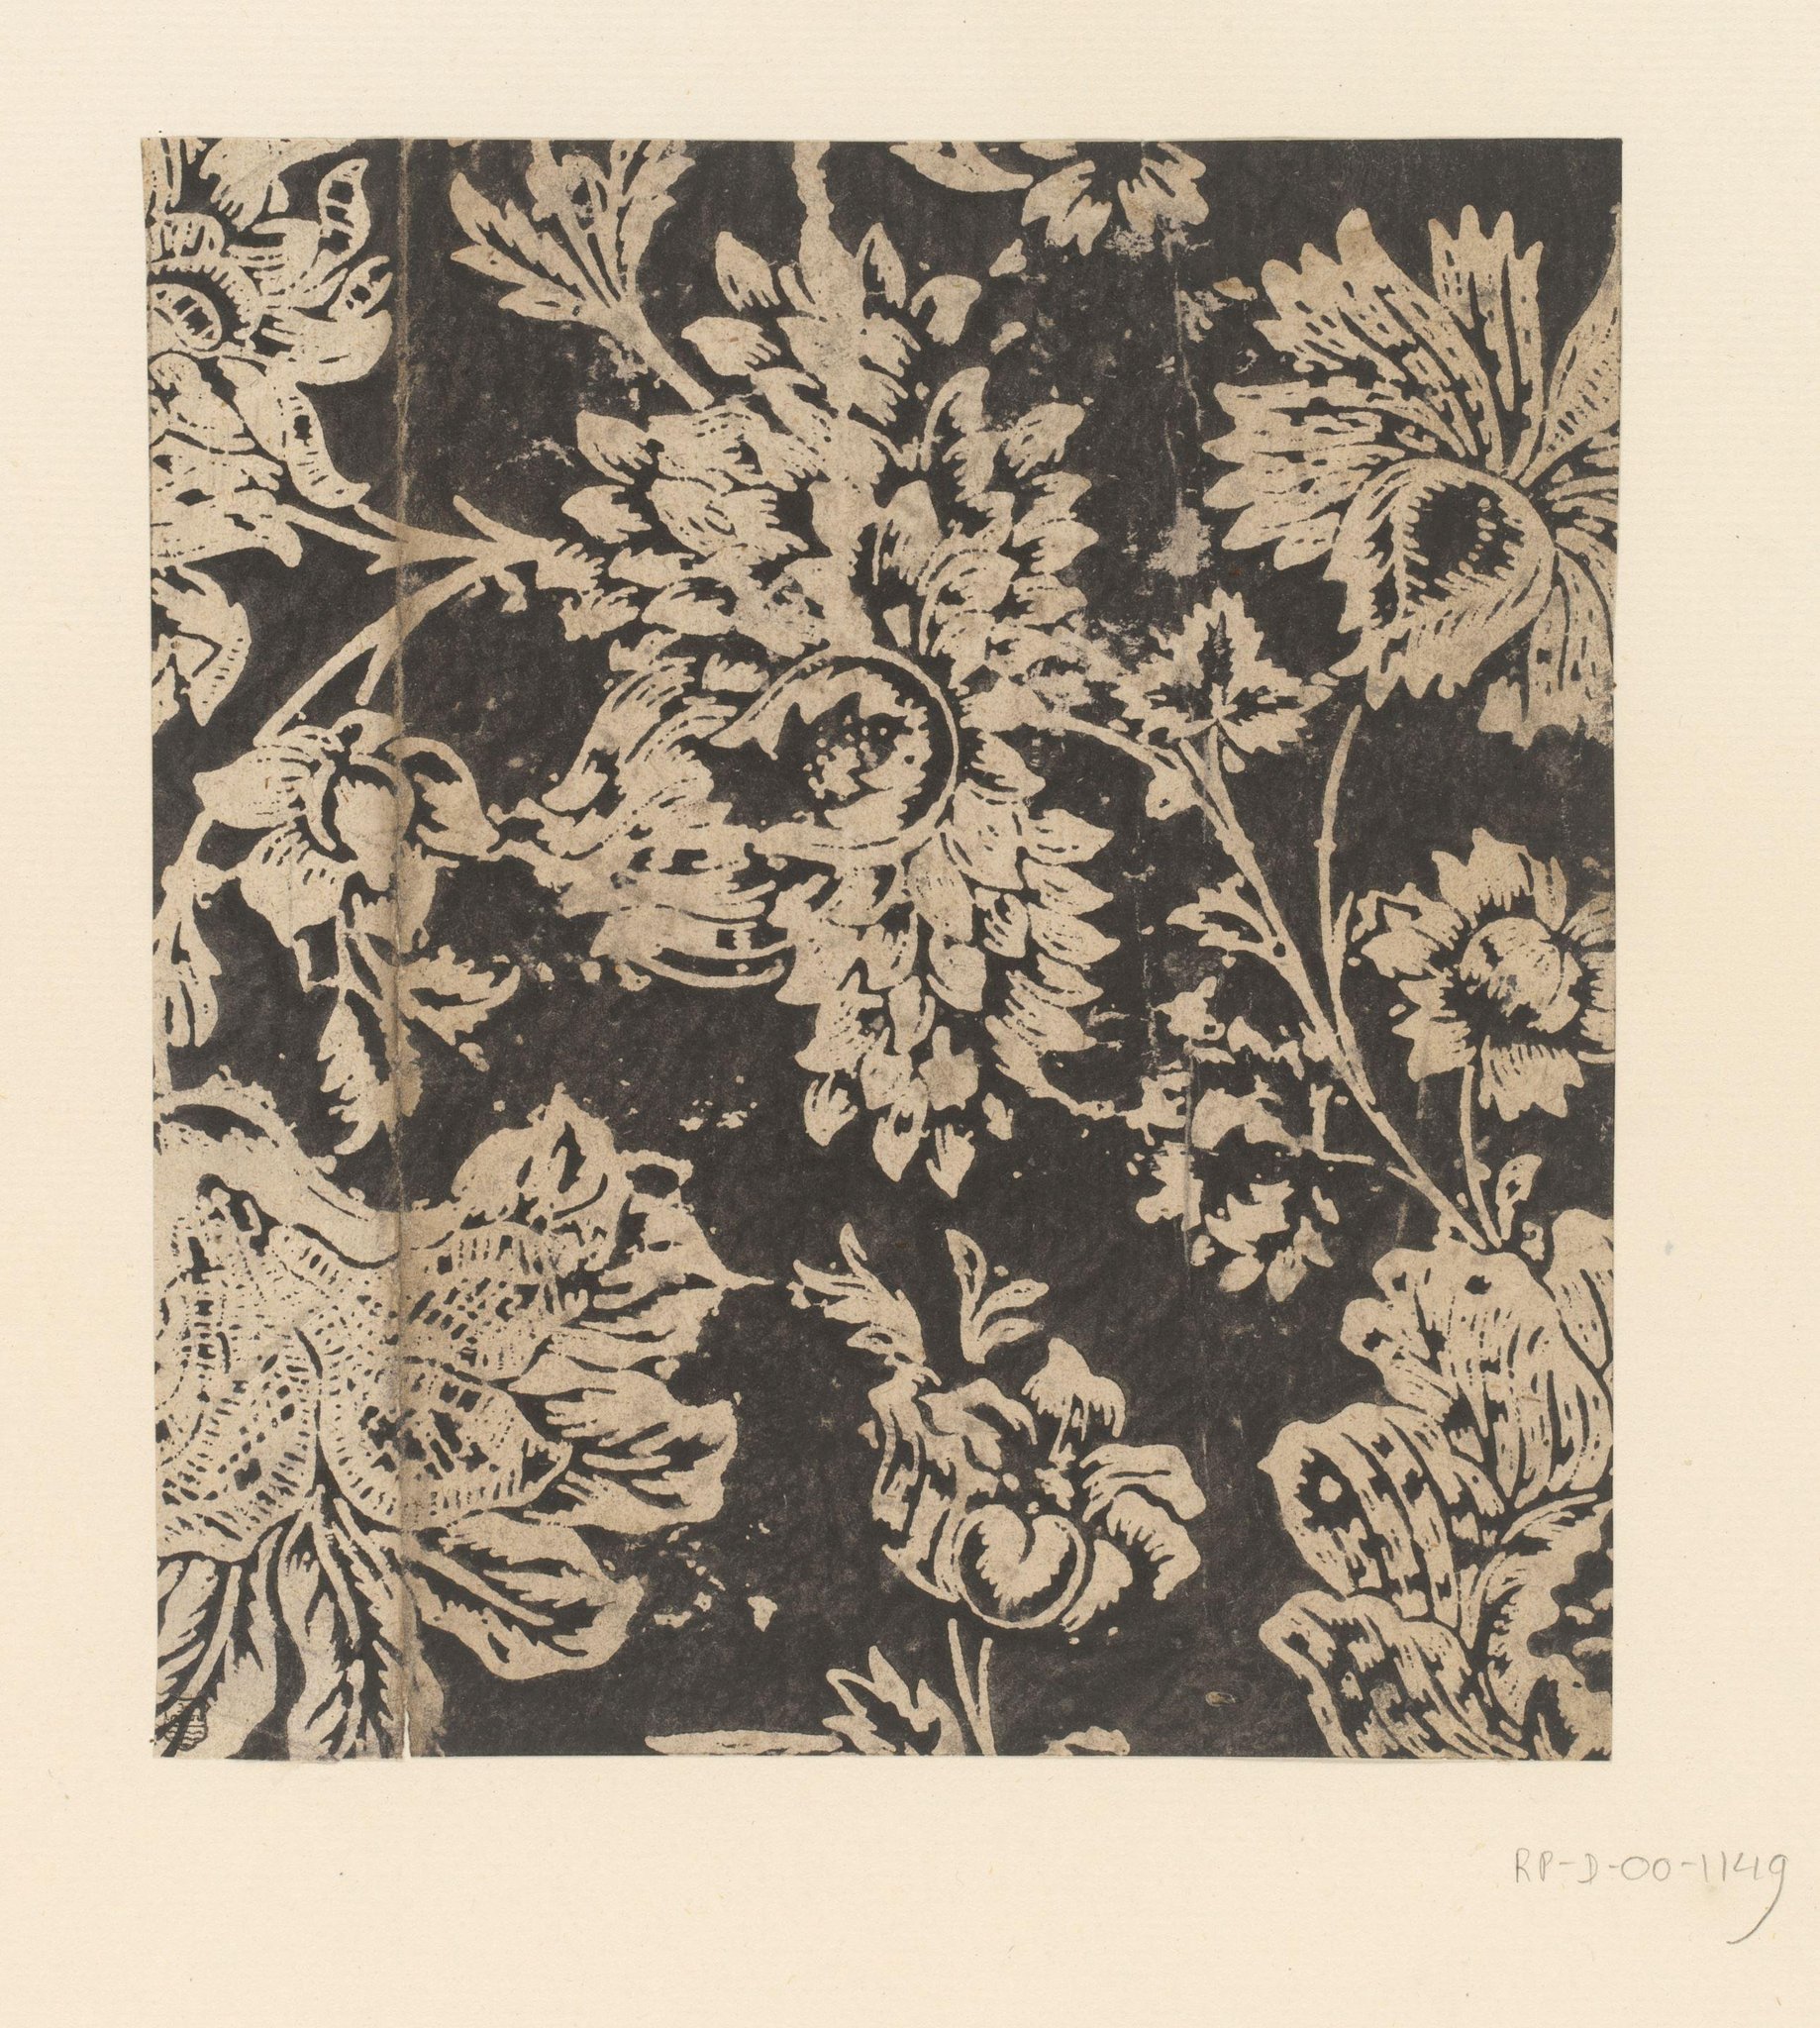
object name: wrapper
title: Blad met patroon van bloemen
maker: Anonymous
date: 1700-1850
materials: paper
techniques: printing block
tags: ornament derived from plant forms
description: Blad met strooipatroon van bloemen. Gebruikt als omslag.